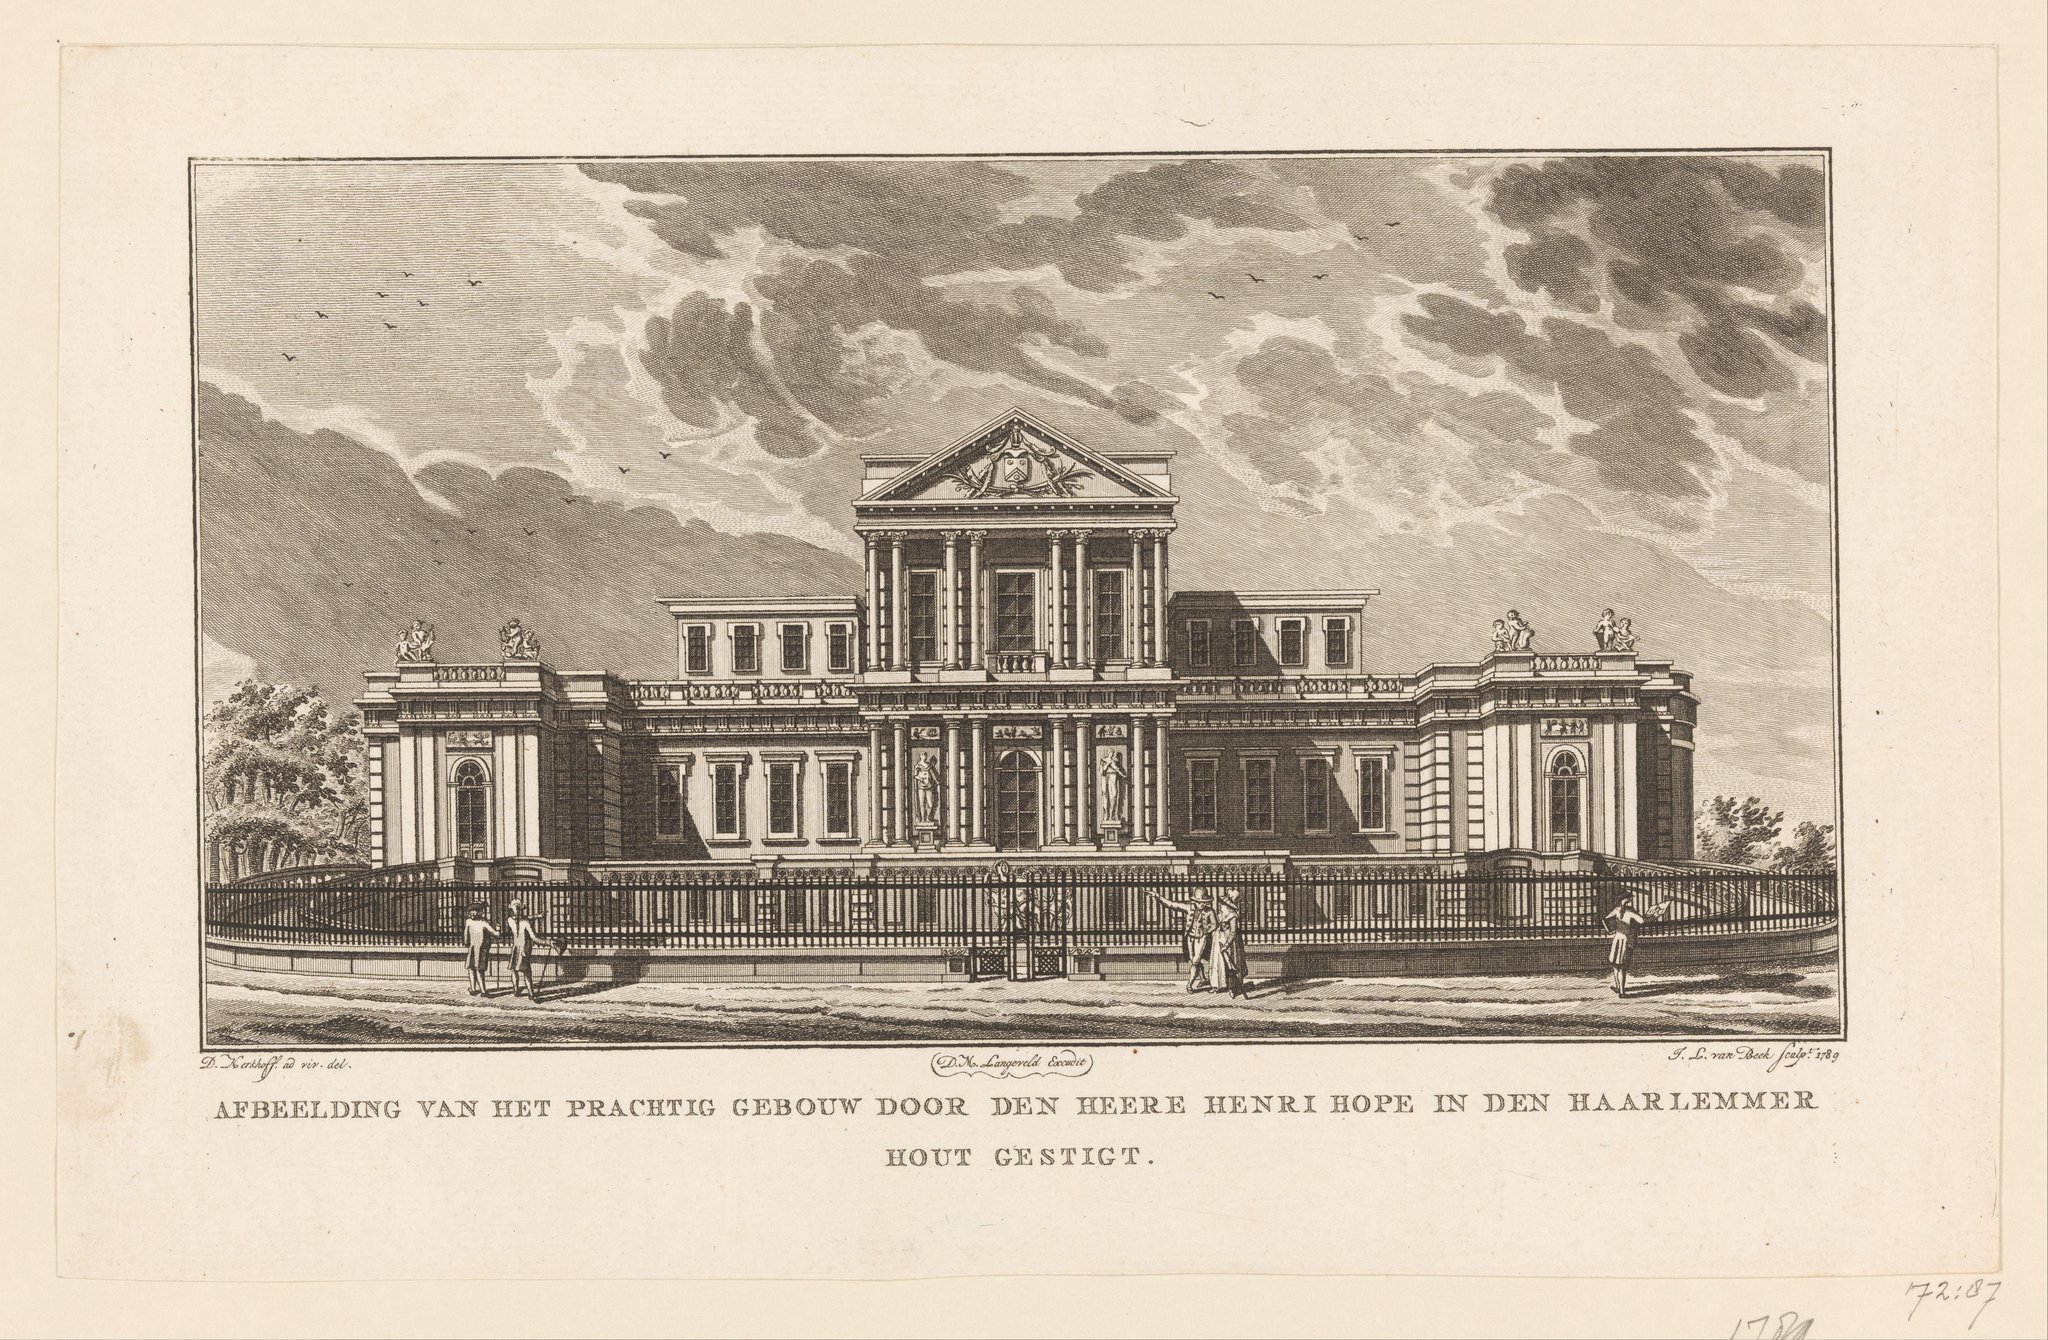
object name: print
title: Afbeelding van het prachtig gebouw door den heere Henri Hope in den Haarlemmer Hout gestigt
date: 1789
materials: paper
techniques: engraving, etching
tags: edifice, e.g.: public building, department store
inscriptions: collector's mark: Lugt 2228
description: Prent uit: Backer, Jan A. De jonge reiziger door Nederland. 3 dln. Amsterdam: D.M. Langeveld, 1789, dl. 1, na p. 154.